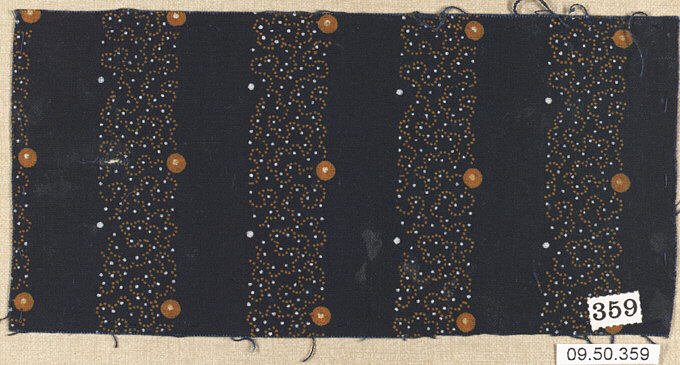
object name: piece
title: Piece (one of 116)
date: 1801-1900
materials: cotton